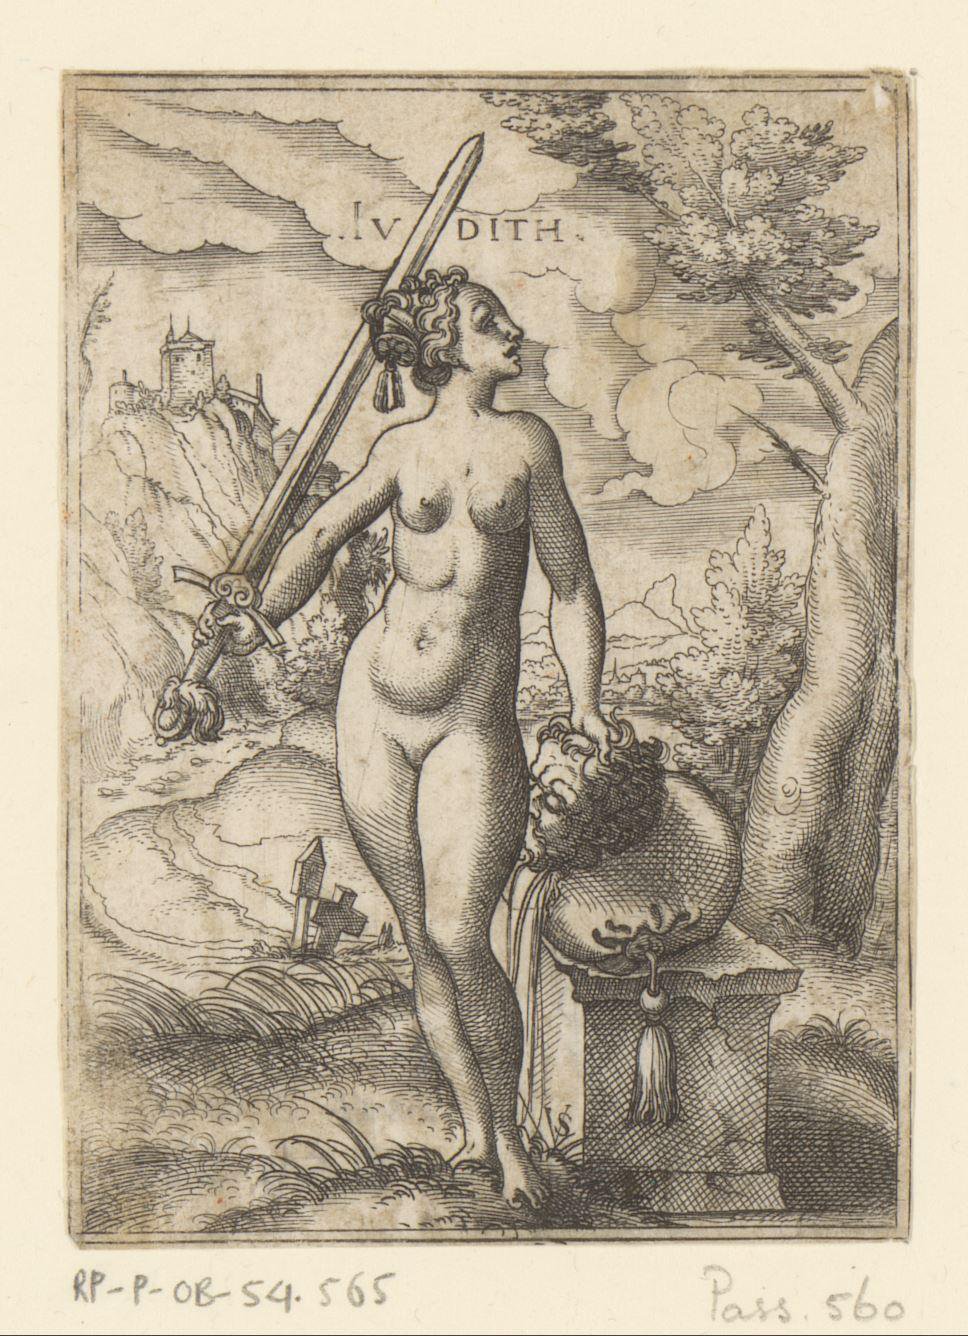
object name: print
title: Iudith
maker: virgilius solis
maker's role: draughtsman, print maker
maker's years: 1514-1562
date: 1524-1562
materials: paper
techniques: engraving, etching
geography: nuremberg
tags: judith with holofernes' head and the sword, judith and holofernes (judith 8-16)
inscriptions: collector's mark: Lugt 2228, number: ‘106’